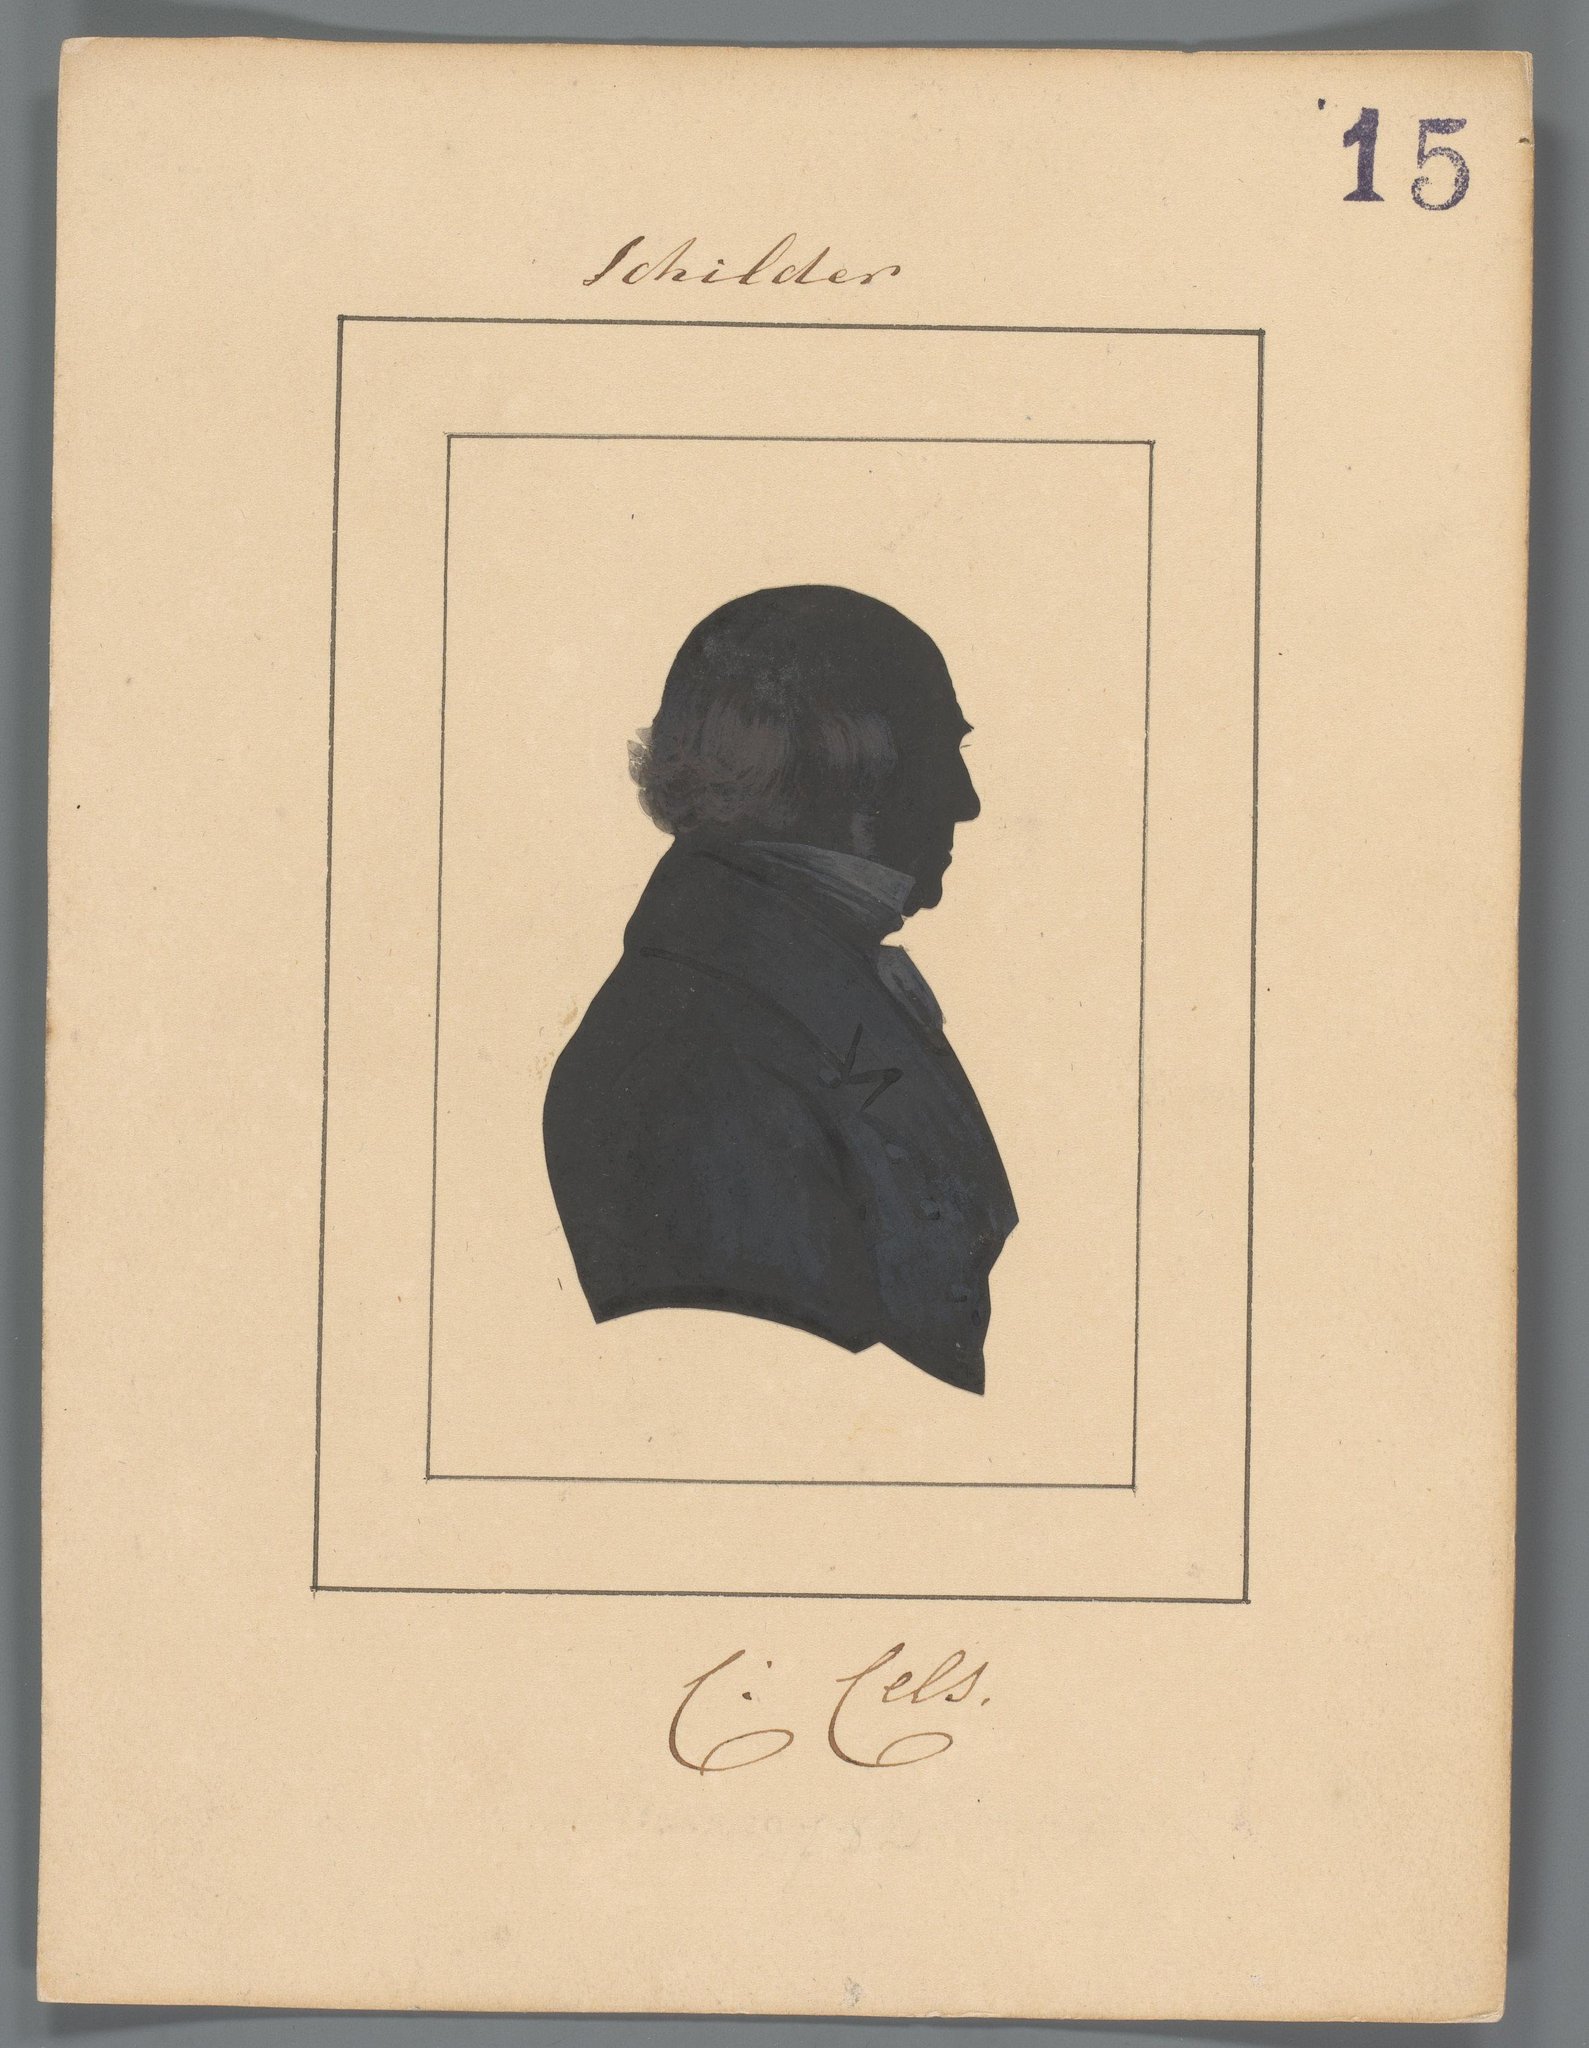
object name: drawing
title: Silhouetportret van Cornelis Cels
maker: elisabeth alida haanen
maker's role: draughtsman, print maker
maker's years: 1809-1845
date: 1819-1845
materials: ink, paint, paper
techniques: brush, snipping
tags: lierre, brussels, draughtsman, cornelis cels, historical persons, portrait, self-portrait of painter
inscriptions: number: ‘15’, number: ‘13957’, inscription: ‘Schilder’, inscription: ‘C: Cels’, inscription: ‘Neg. D. 1749’, collector's mark: ‘Ex-libris van Beresteyn’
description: Met onder het portret de handtekening van de geportretteerde.